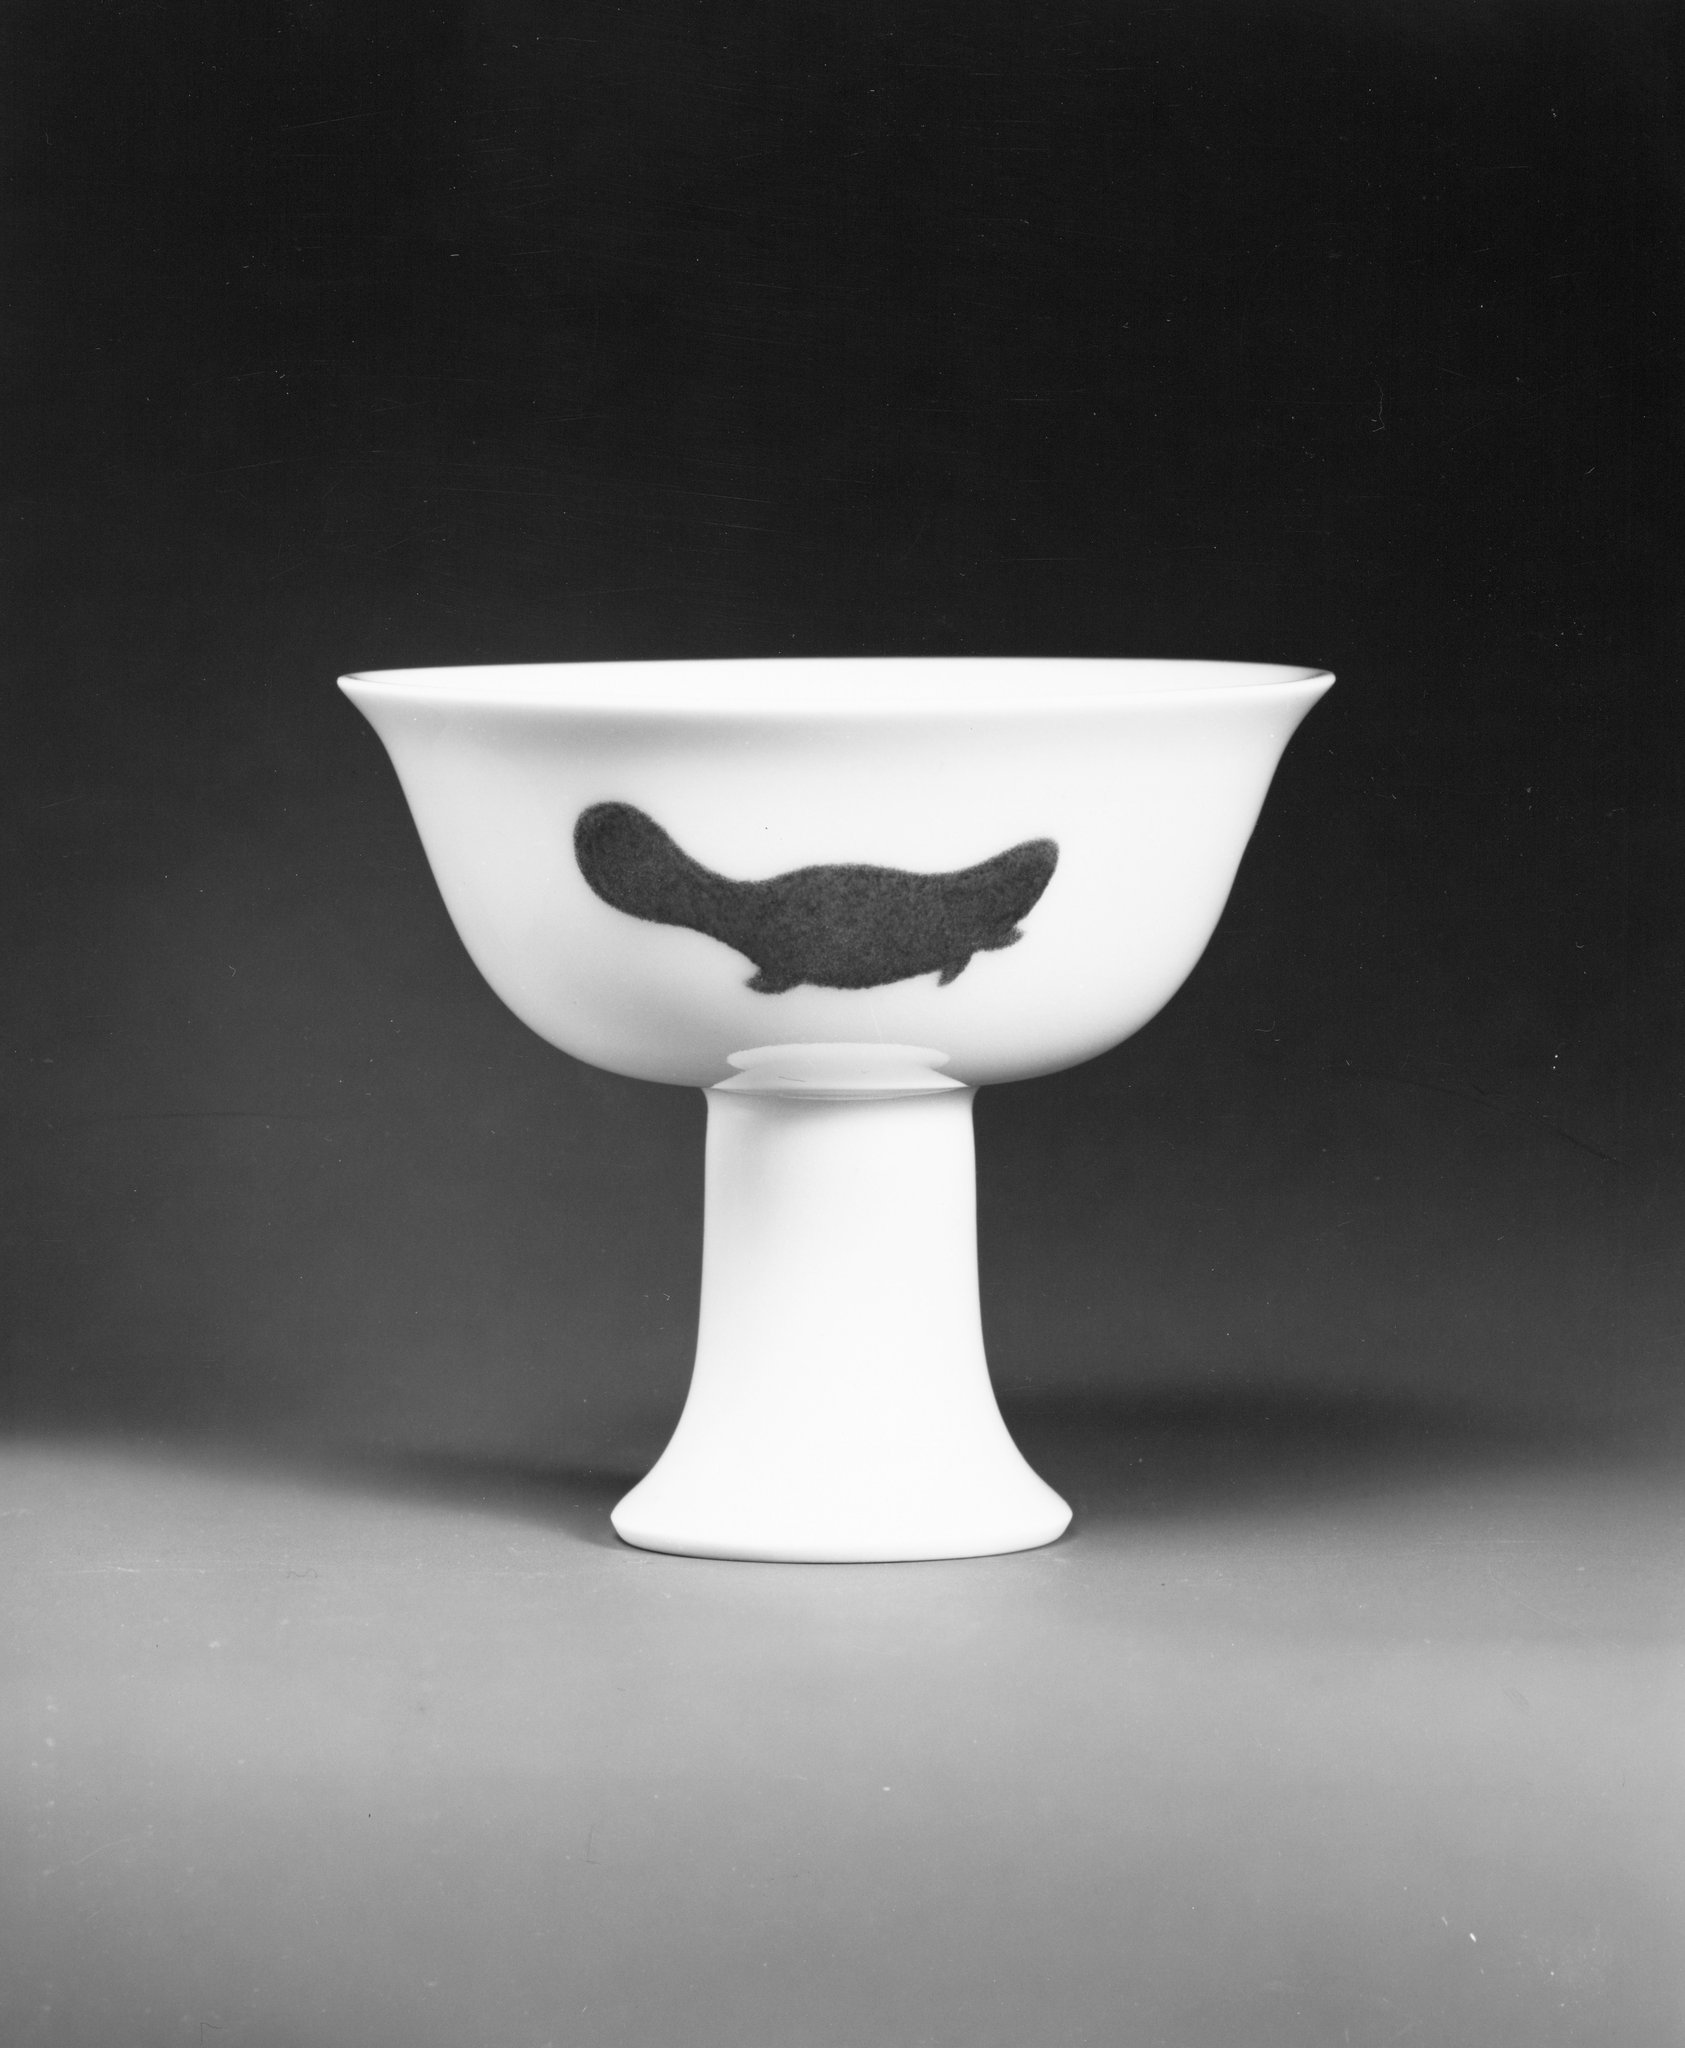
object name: ceramic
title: Stem Cup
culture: chinese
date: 1901-2000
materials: porcelain